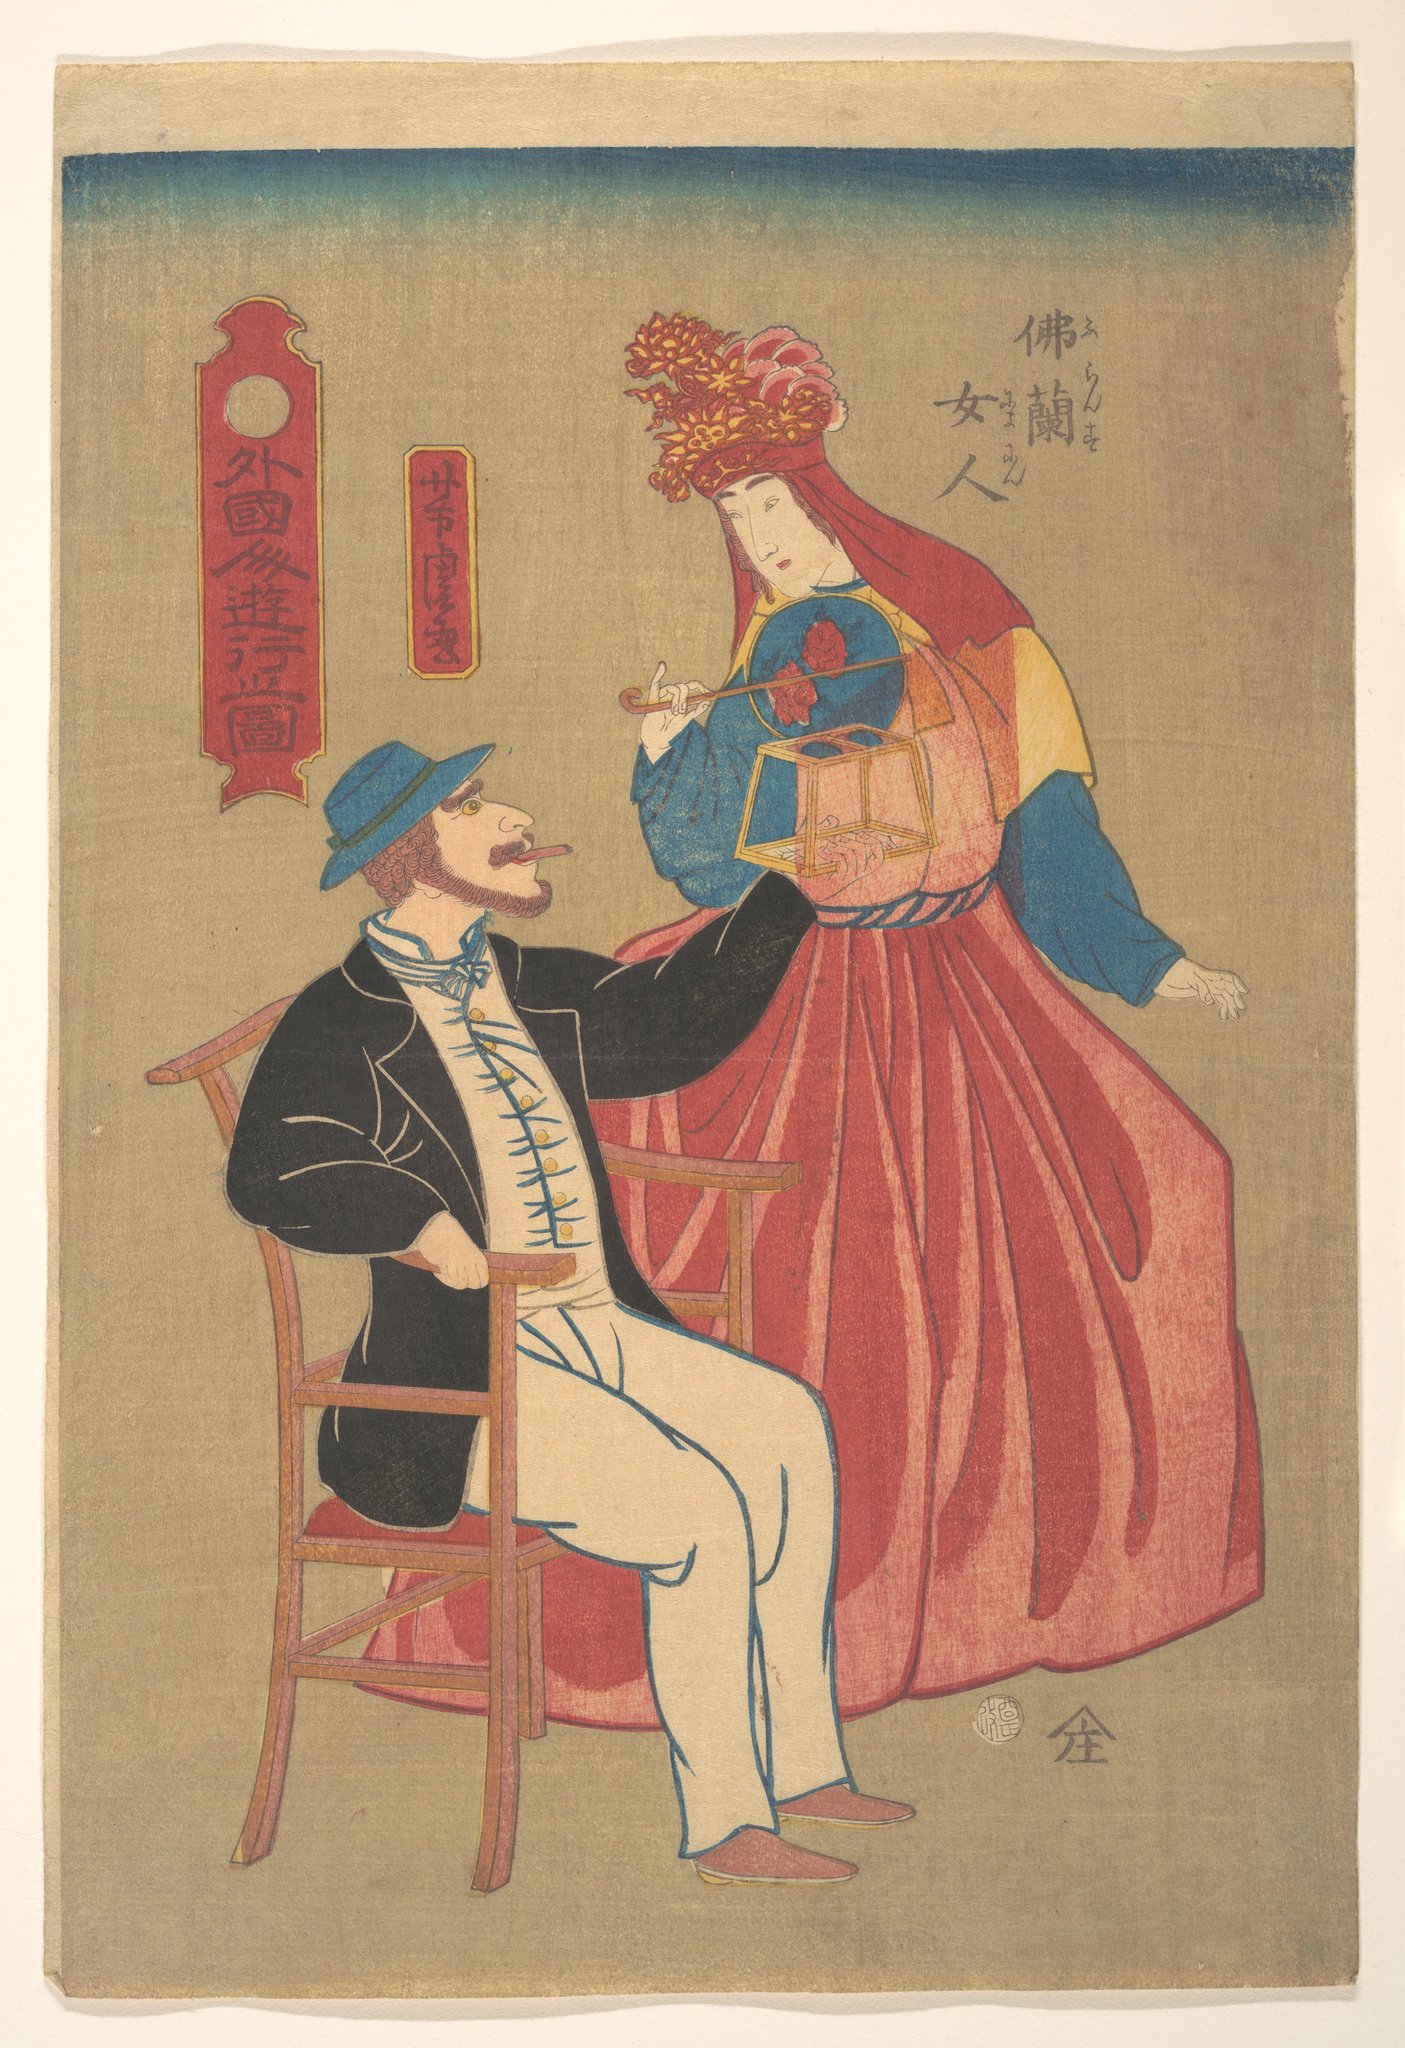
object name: print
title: French Housewife and Her Husband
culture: japanese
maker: utagawa yoshitora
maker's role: artist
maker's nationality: japanese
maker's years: 1845-1880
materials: ink, paper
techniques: woodblock print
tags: couples,men,women